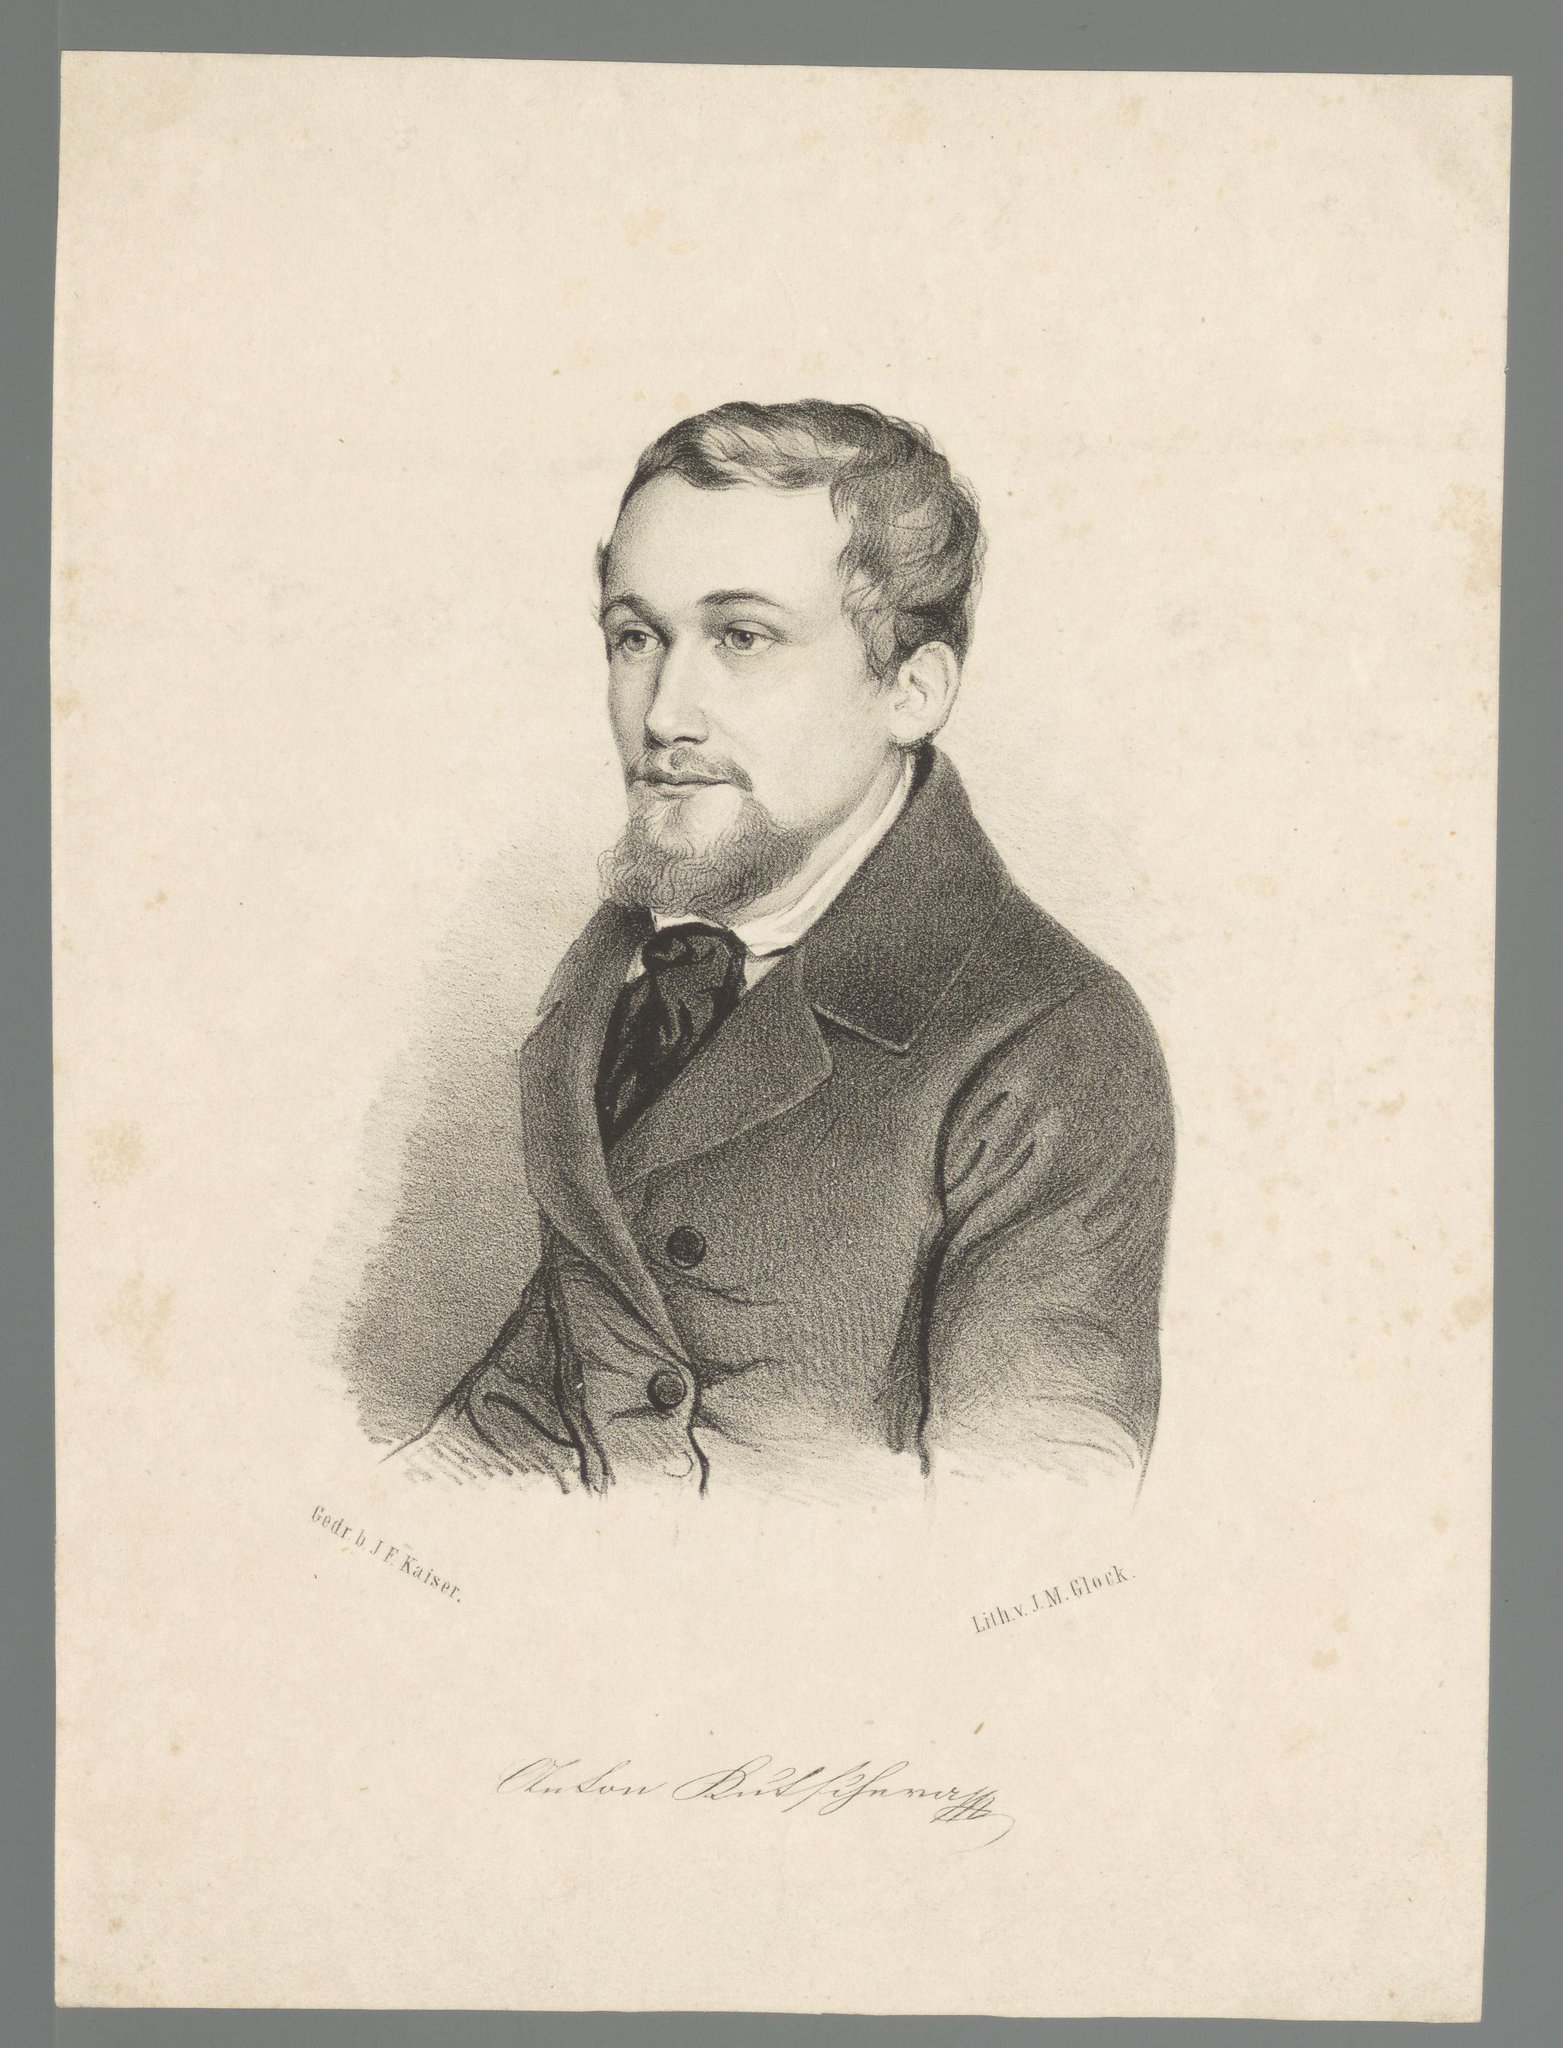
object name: print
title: Portret van een onbekende man, mogelijk Anton Kutschera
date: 1800-1850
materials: paper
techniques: lithograph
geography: graz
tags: adult man, historical persons, beard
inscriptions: collector's mark: Lugt 2228